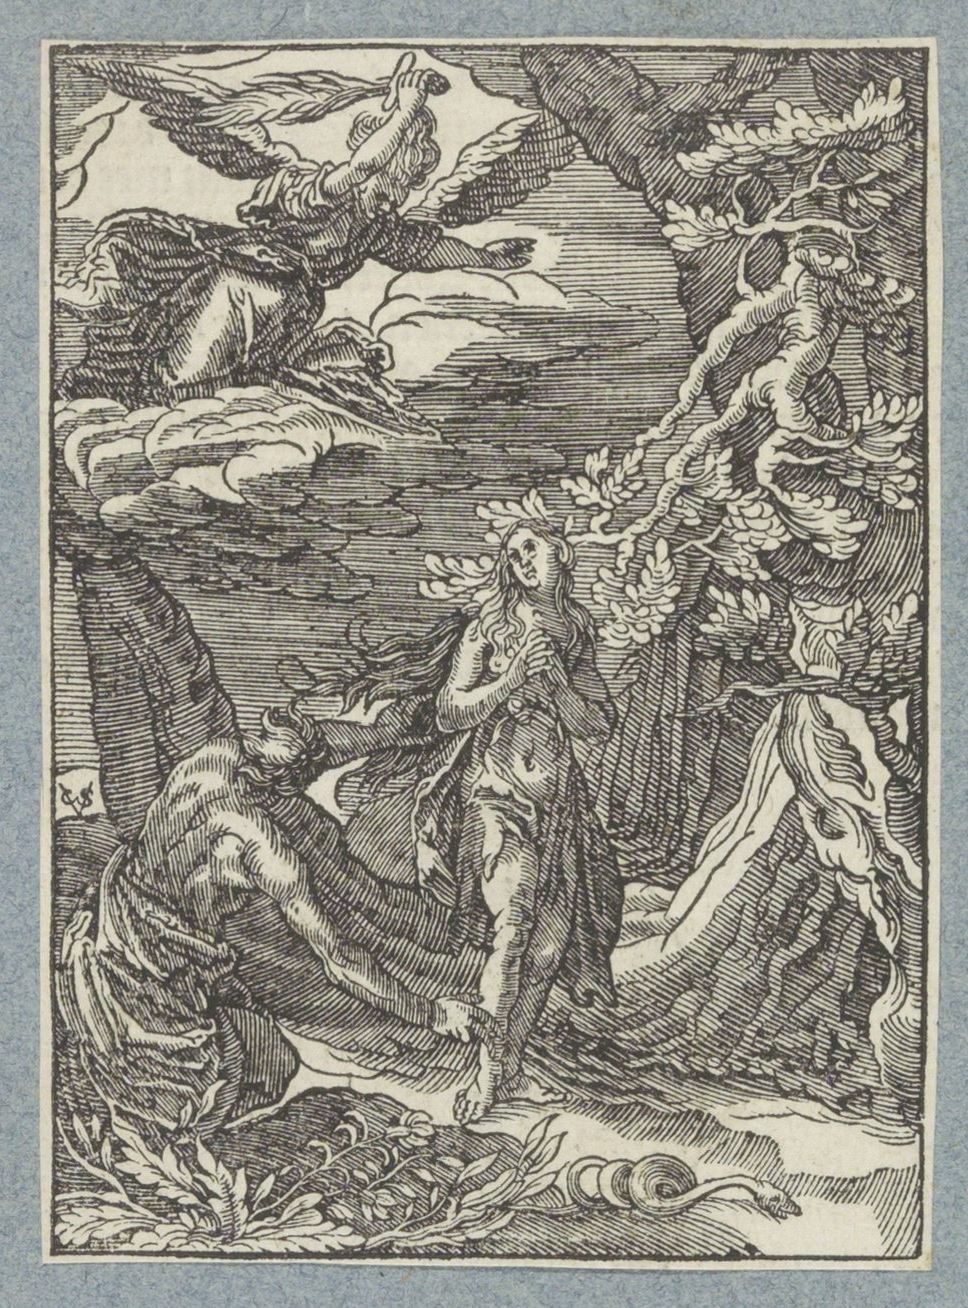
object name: album leaf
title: Expulsion from Paradise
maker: pieter jacobsz. paets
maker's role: publisher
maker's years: 1587-1667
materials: paper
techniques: letterpress printing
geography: amsterdam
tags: expulsion of adam and eve from paradise (genesis 3:22-24)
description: De prent is afkomstig uit een van de uitgaven van P.J. Paets uit Amsterdam. Ze komt in ieder geval voor in: Bibels tresoor ofte der zielen lusthof. Amsterdam, P.J. Paets, 1646. De voorstelling is gekopieerd naar een prent van Jan Saenredam naar ontwerp van Abraham Bloemaert.